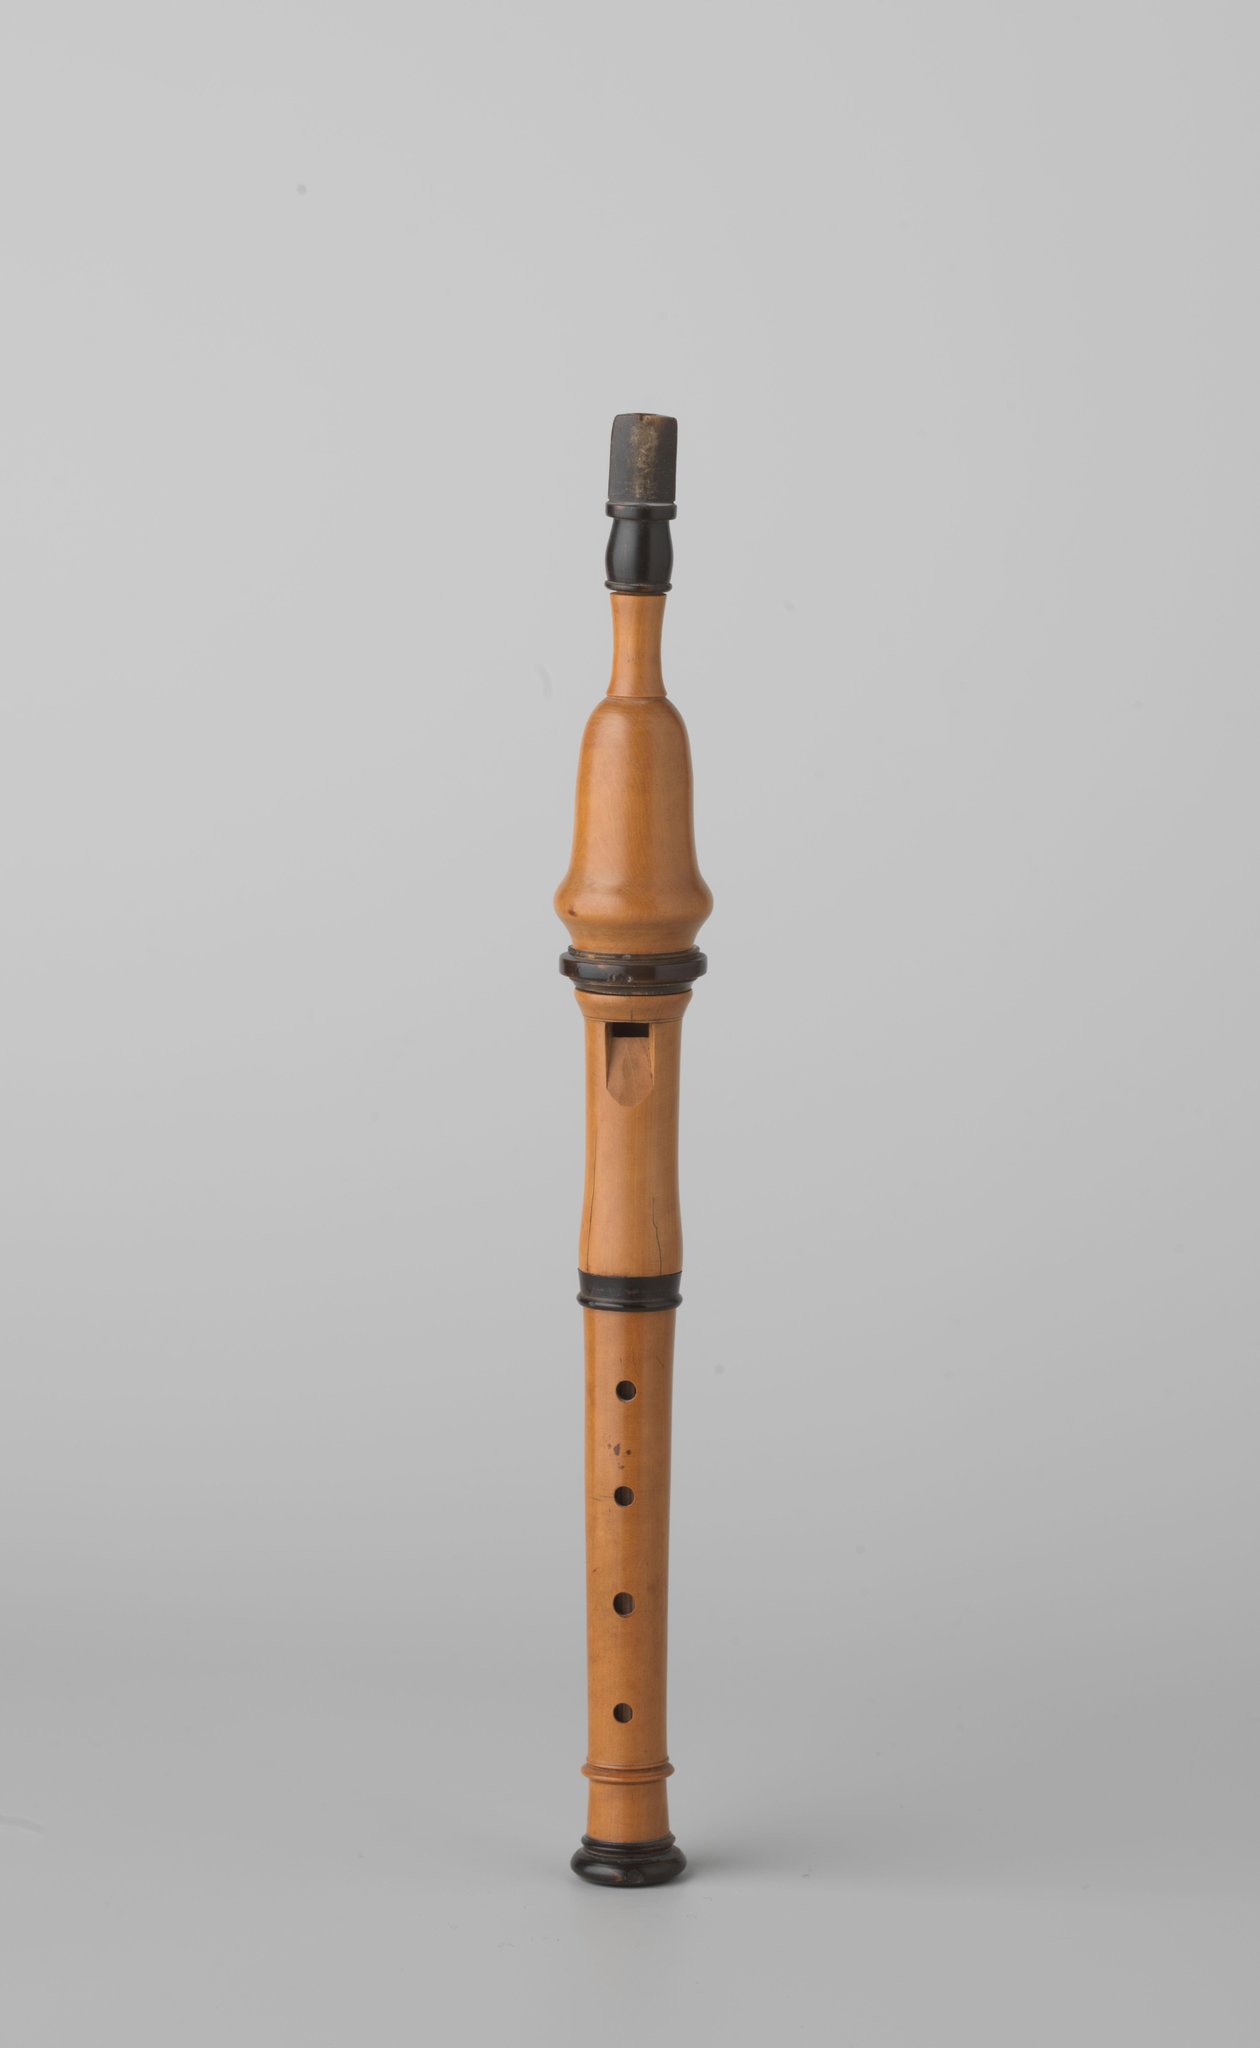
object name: musical instrument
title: French flageolet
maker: Anonymous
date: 1800-1849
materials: wood, horn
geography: france